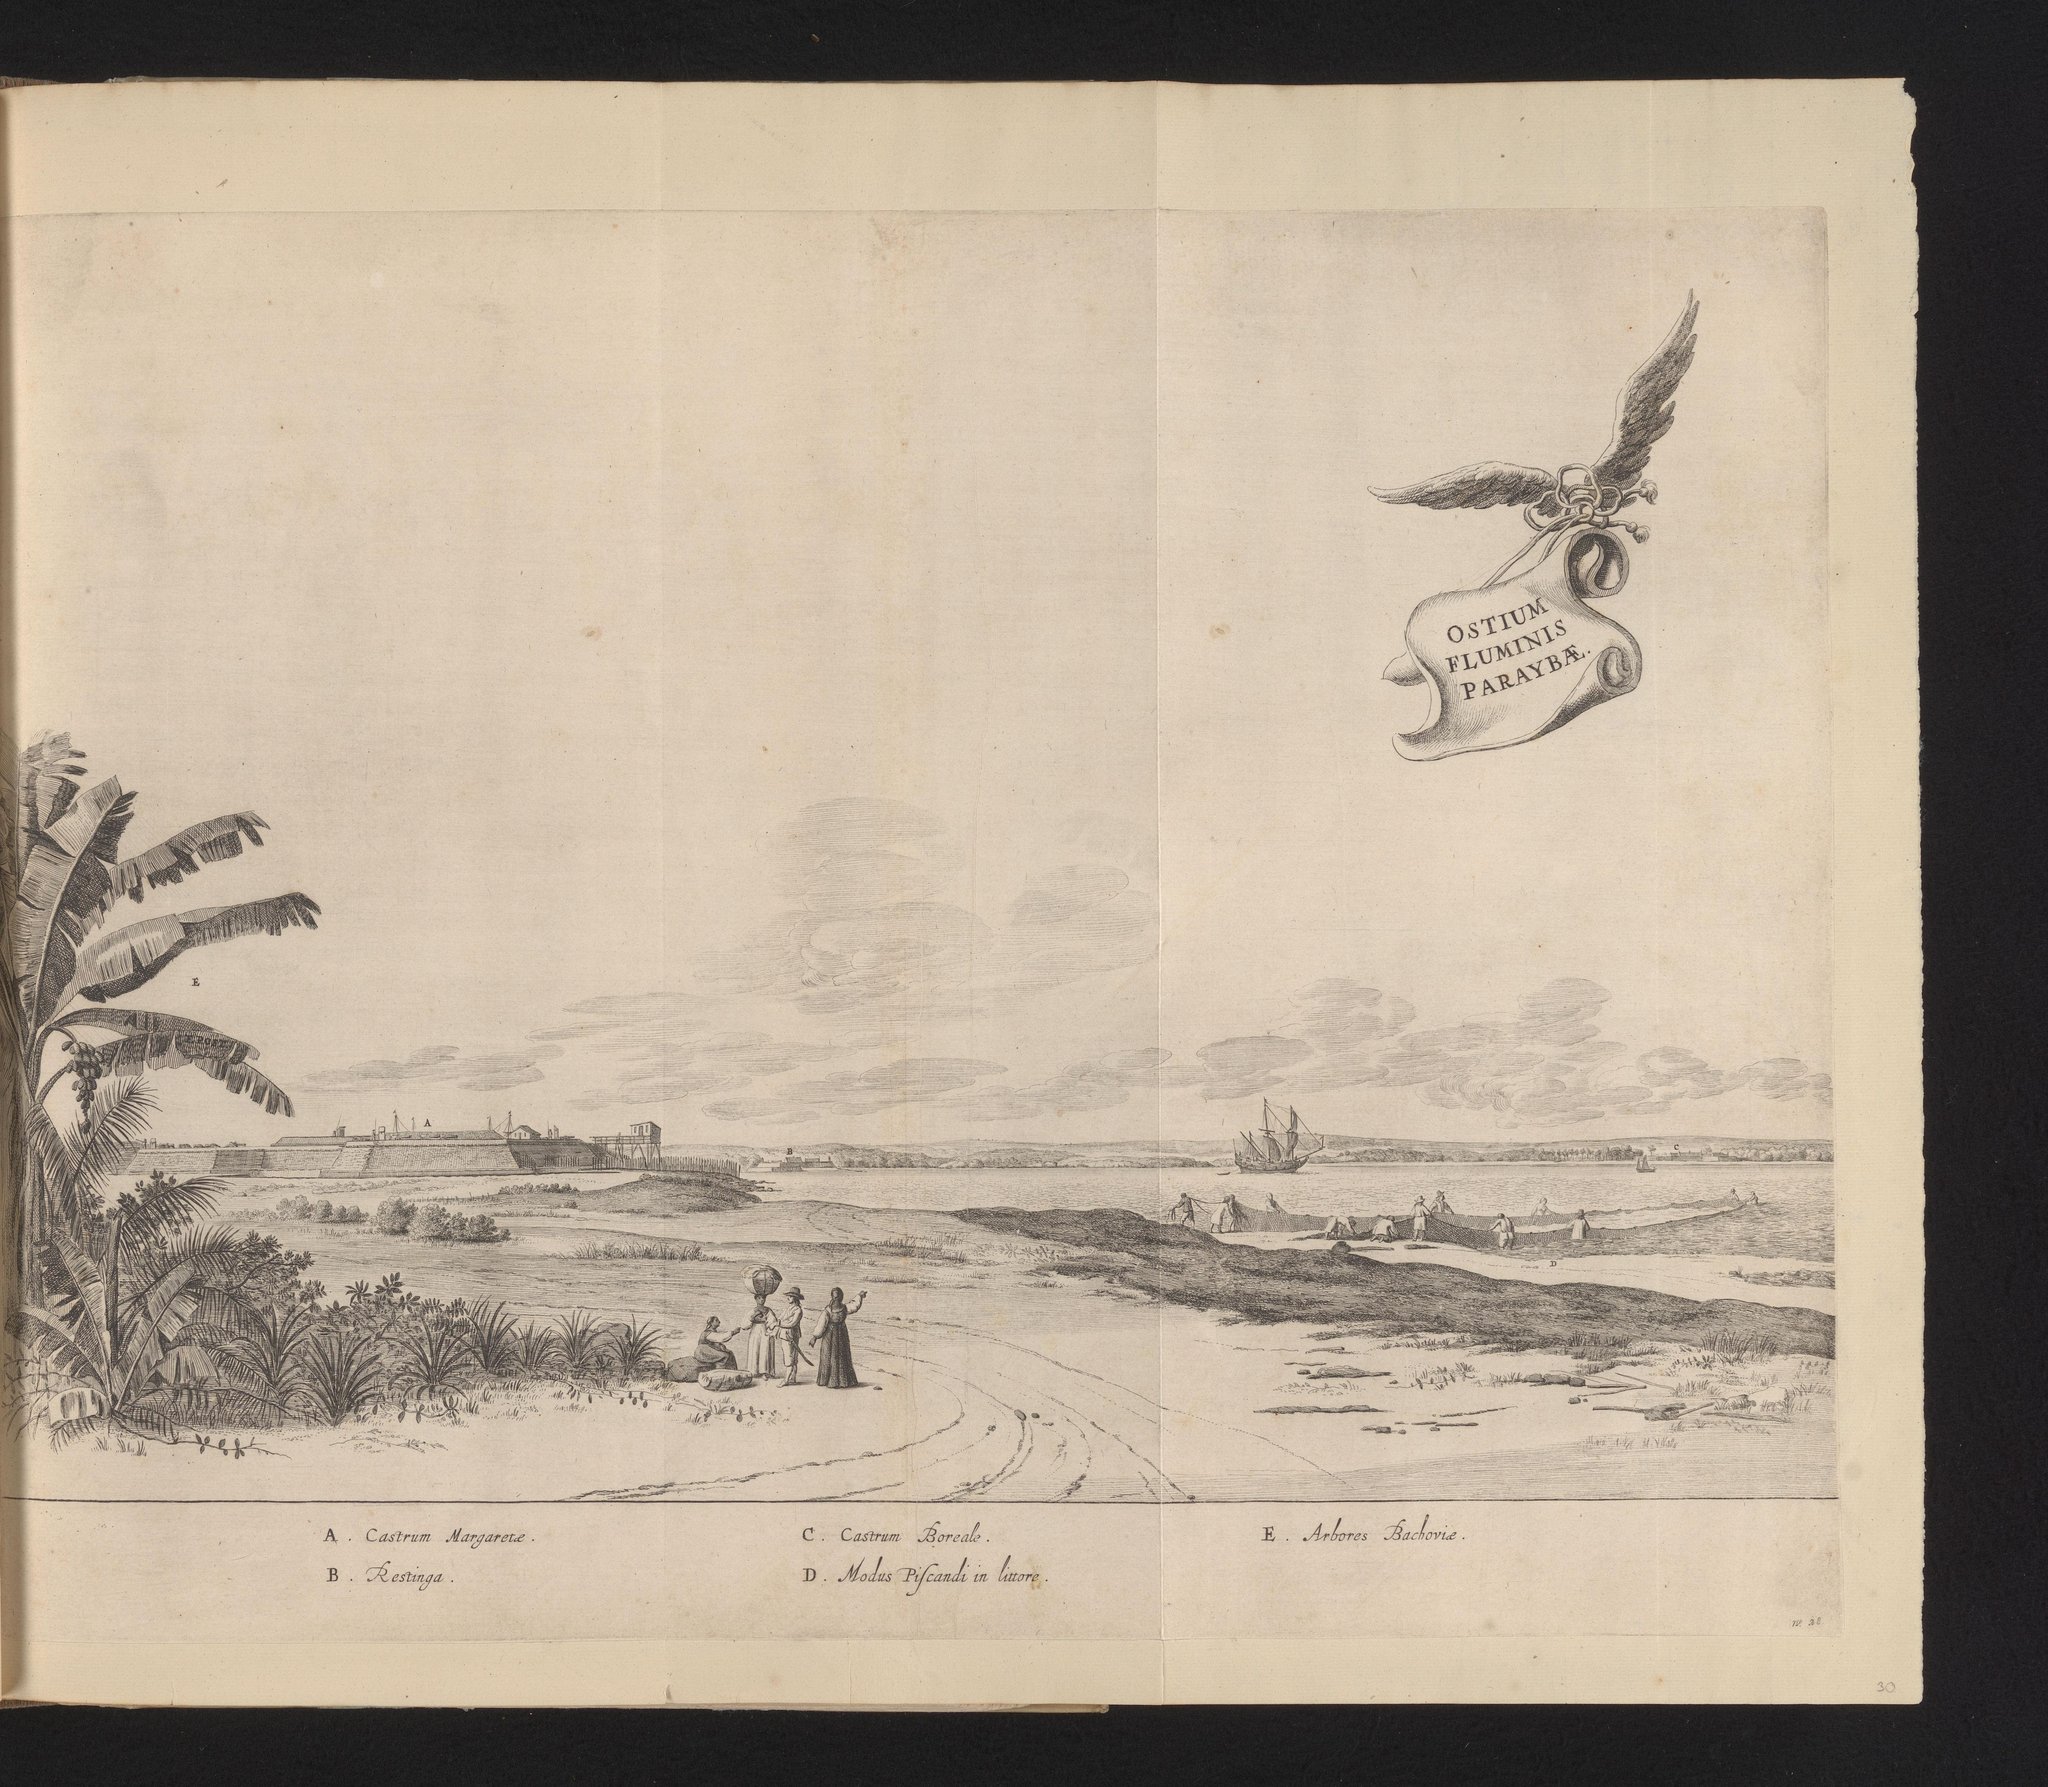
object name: print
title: Gezicht op de forten aan de monding van de Paraiba, ca. 1636-1644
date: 1645-1647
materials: paper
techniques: engraving, etching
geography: amsterdam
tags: earl, johan maurits graaf van nassau-siegen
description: Gezicht op de forten gelegen aan de monding van de rivier Rio Paraiba, ca. 1636-1644. Rechts gaan vissers met hun net in het water. In de lucht een gevleugelde banderol met de titel. In het onderschrift de verklaring van de letters A-E in het Latijn. Plaat nr. 28 in een serie van 55 voorstellingen van de tocht naar en het verblijf in Brazilië van graaf Johan Maurits van Nassau in de jaren 1636-1644.